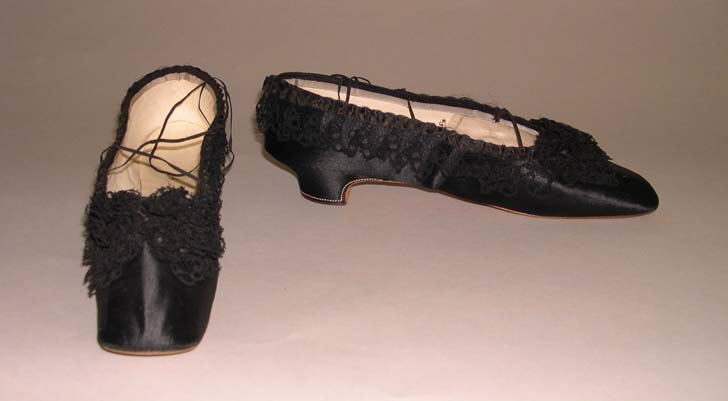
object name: slipper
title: Slippers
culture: french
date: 1850-1859